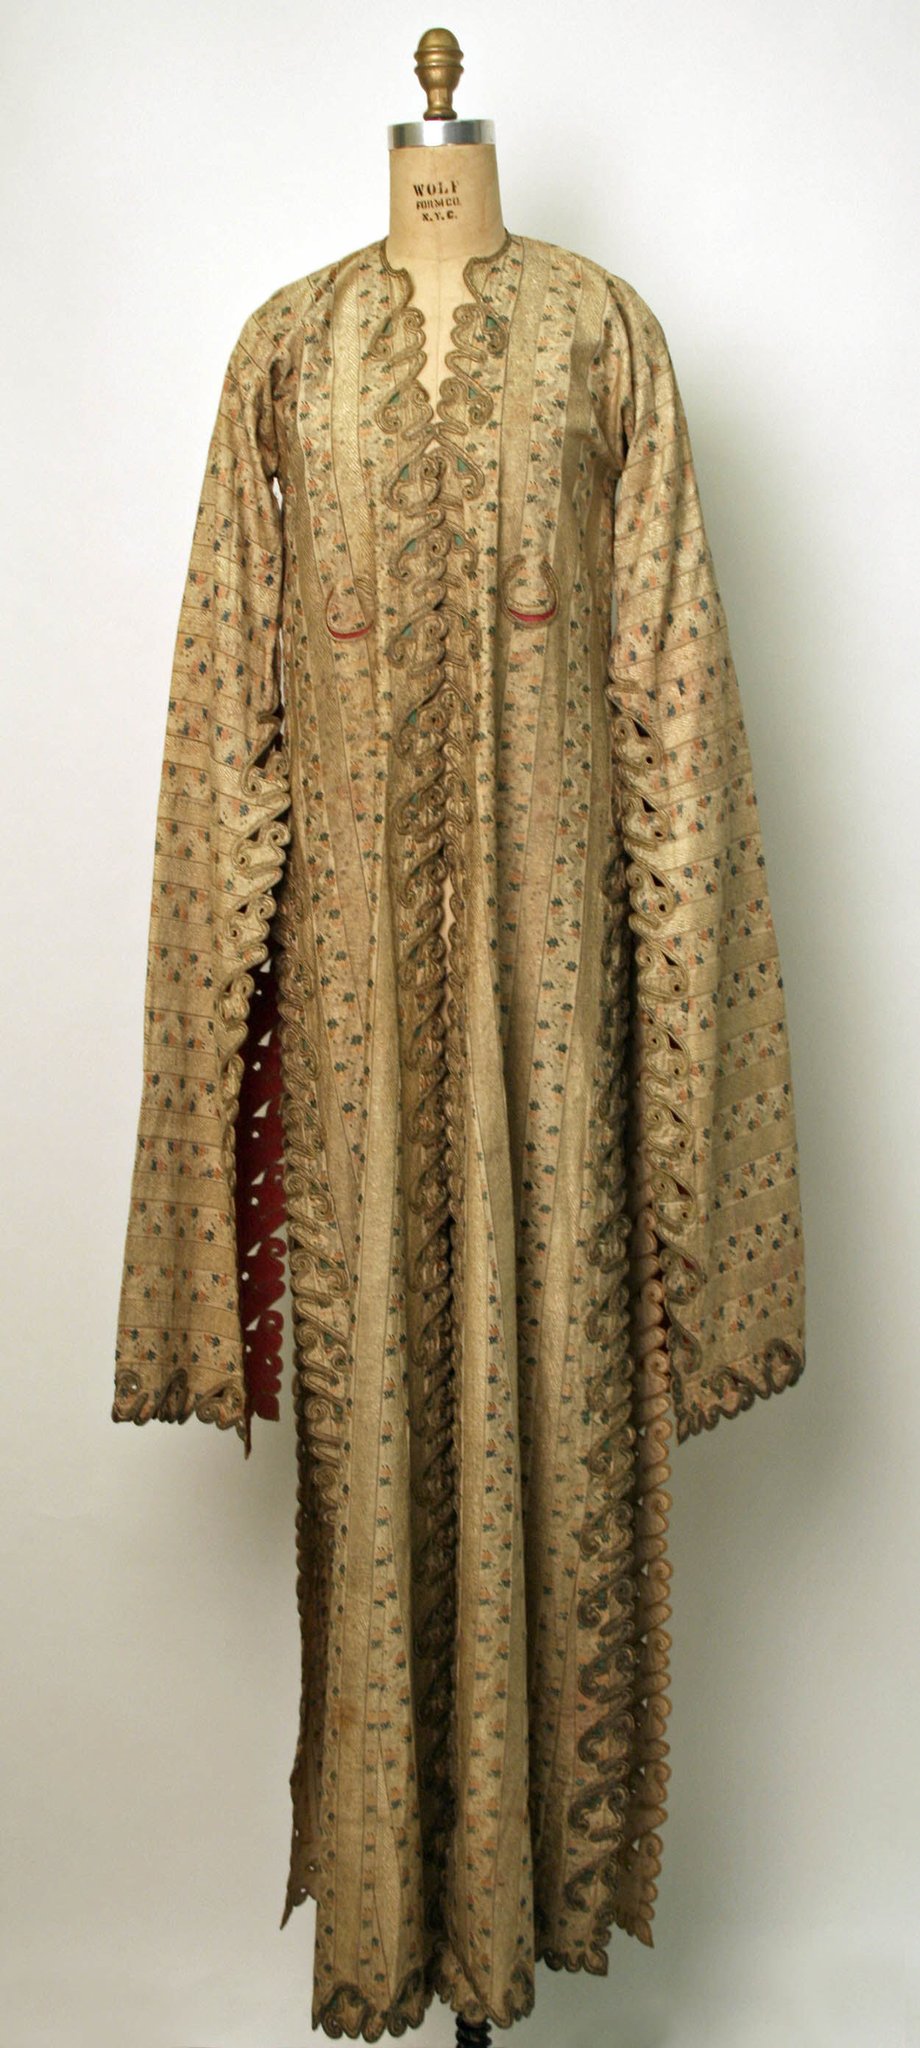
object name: robe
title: Uçetek Entari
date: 1801-1900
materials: metal thread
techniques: brocade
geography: turkey